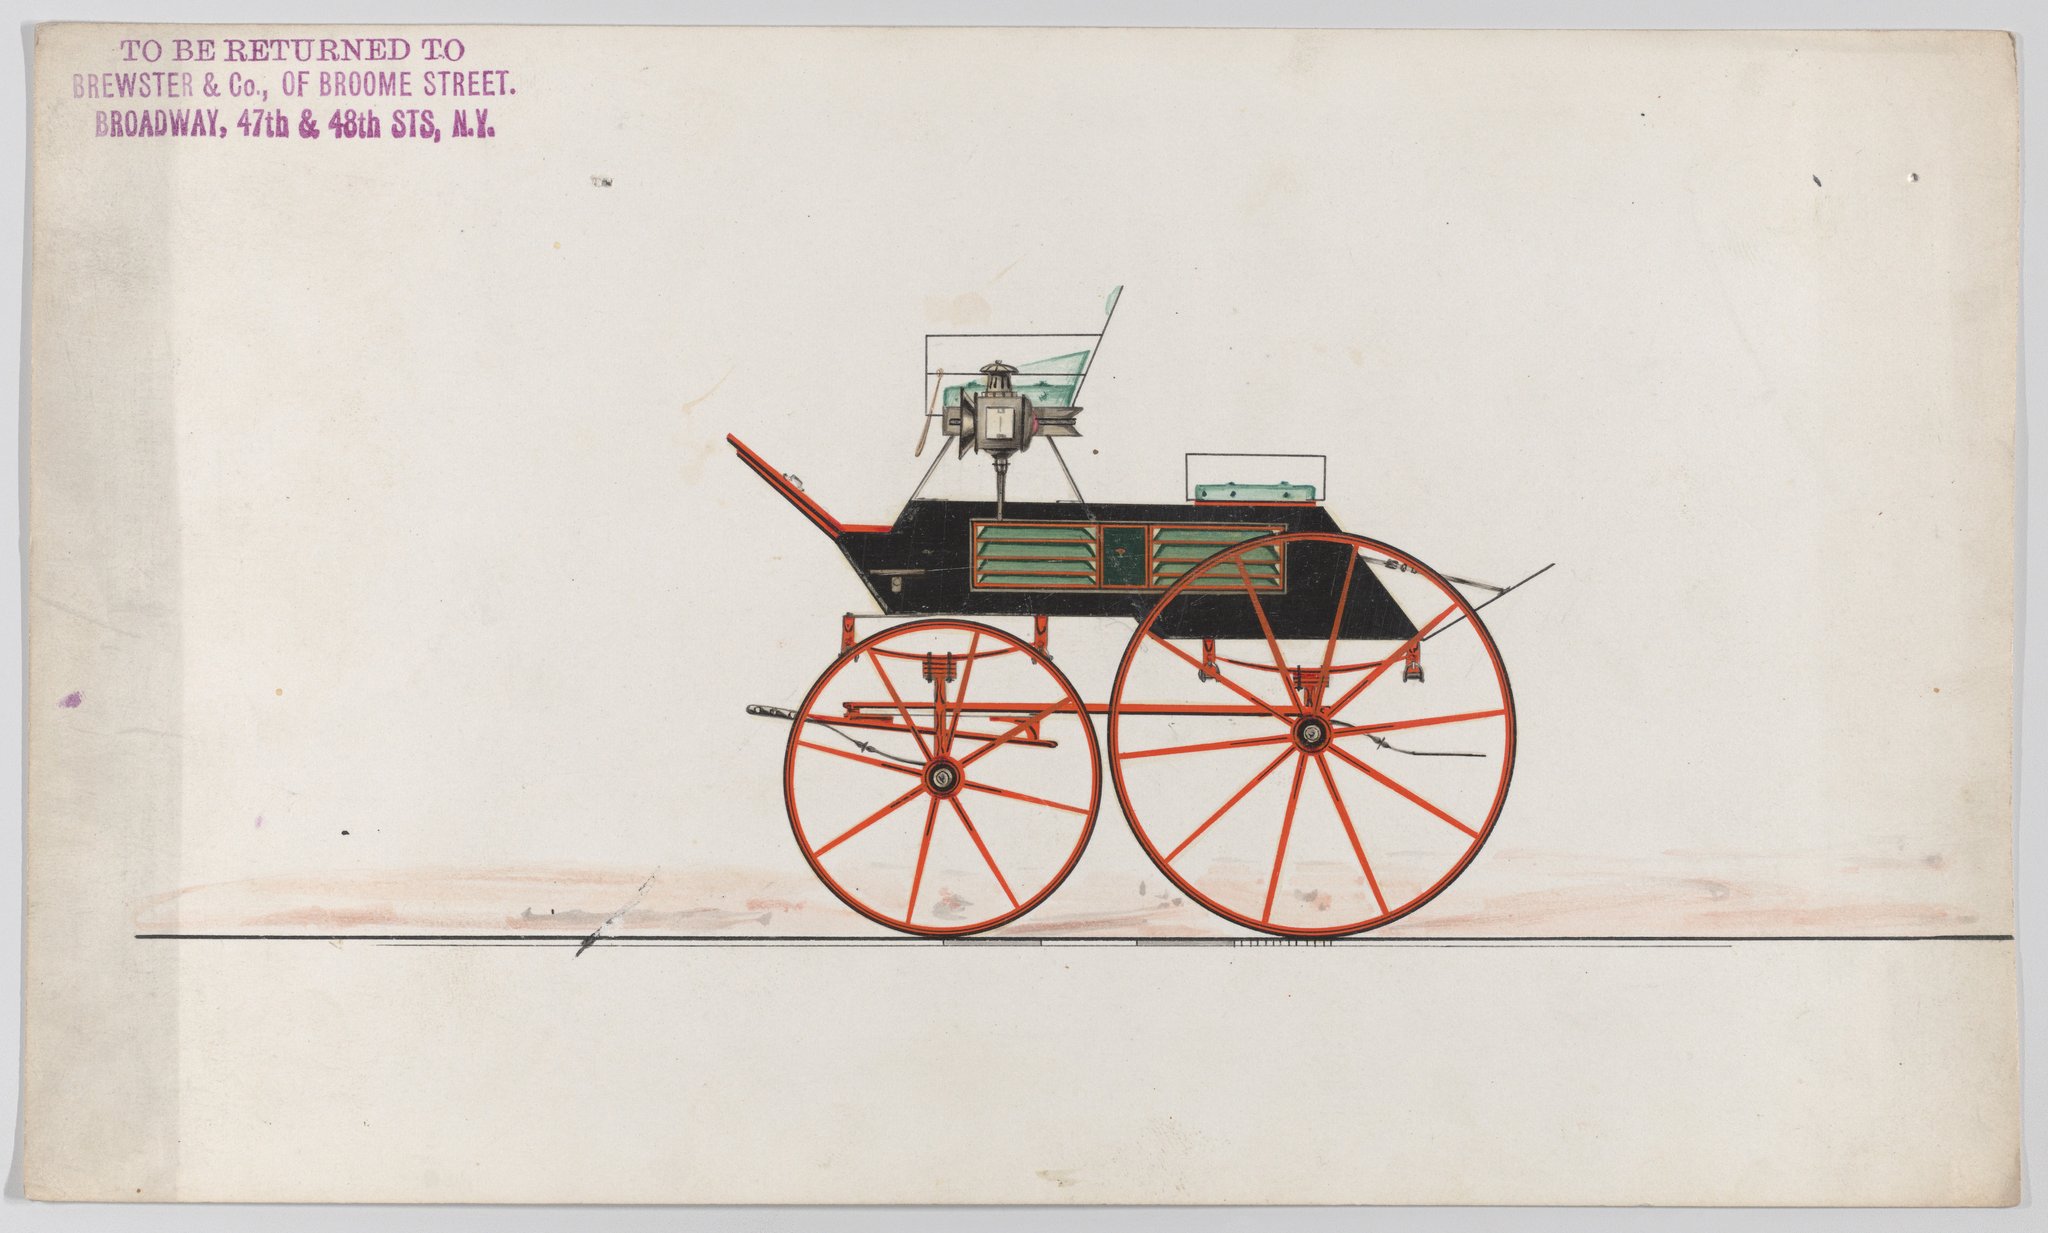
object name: drawing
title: Design for Game Wagon (unnumbered)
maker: brewster & co.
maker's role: manufacturer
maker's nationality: american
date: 1880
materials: gouache, gum arabic, ink, watercolor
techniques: pen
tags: carriages